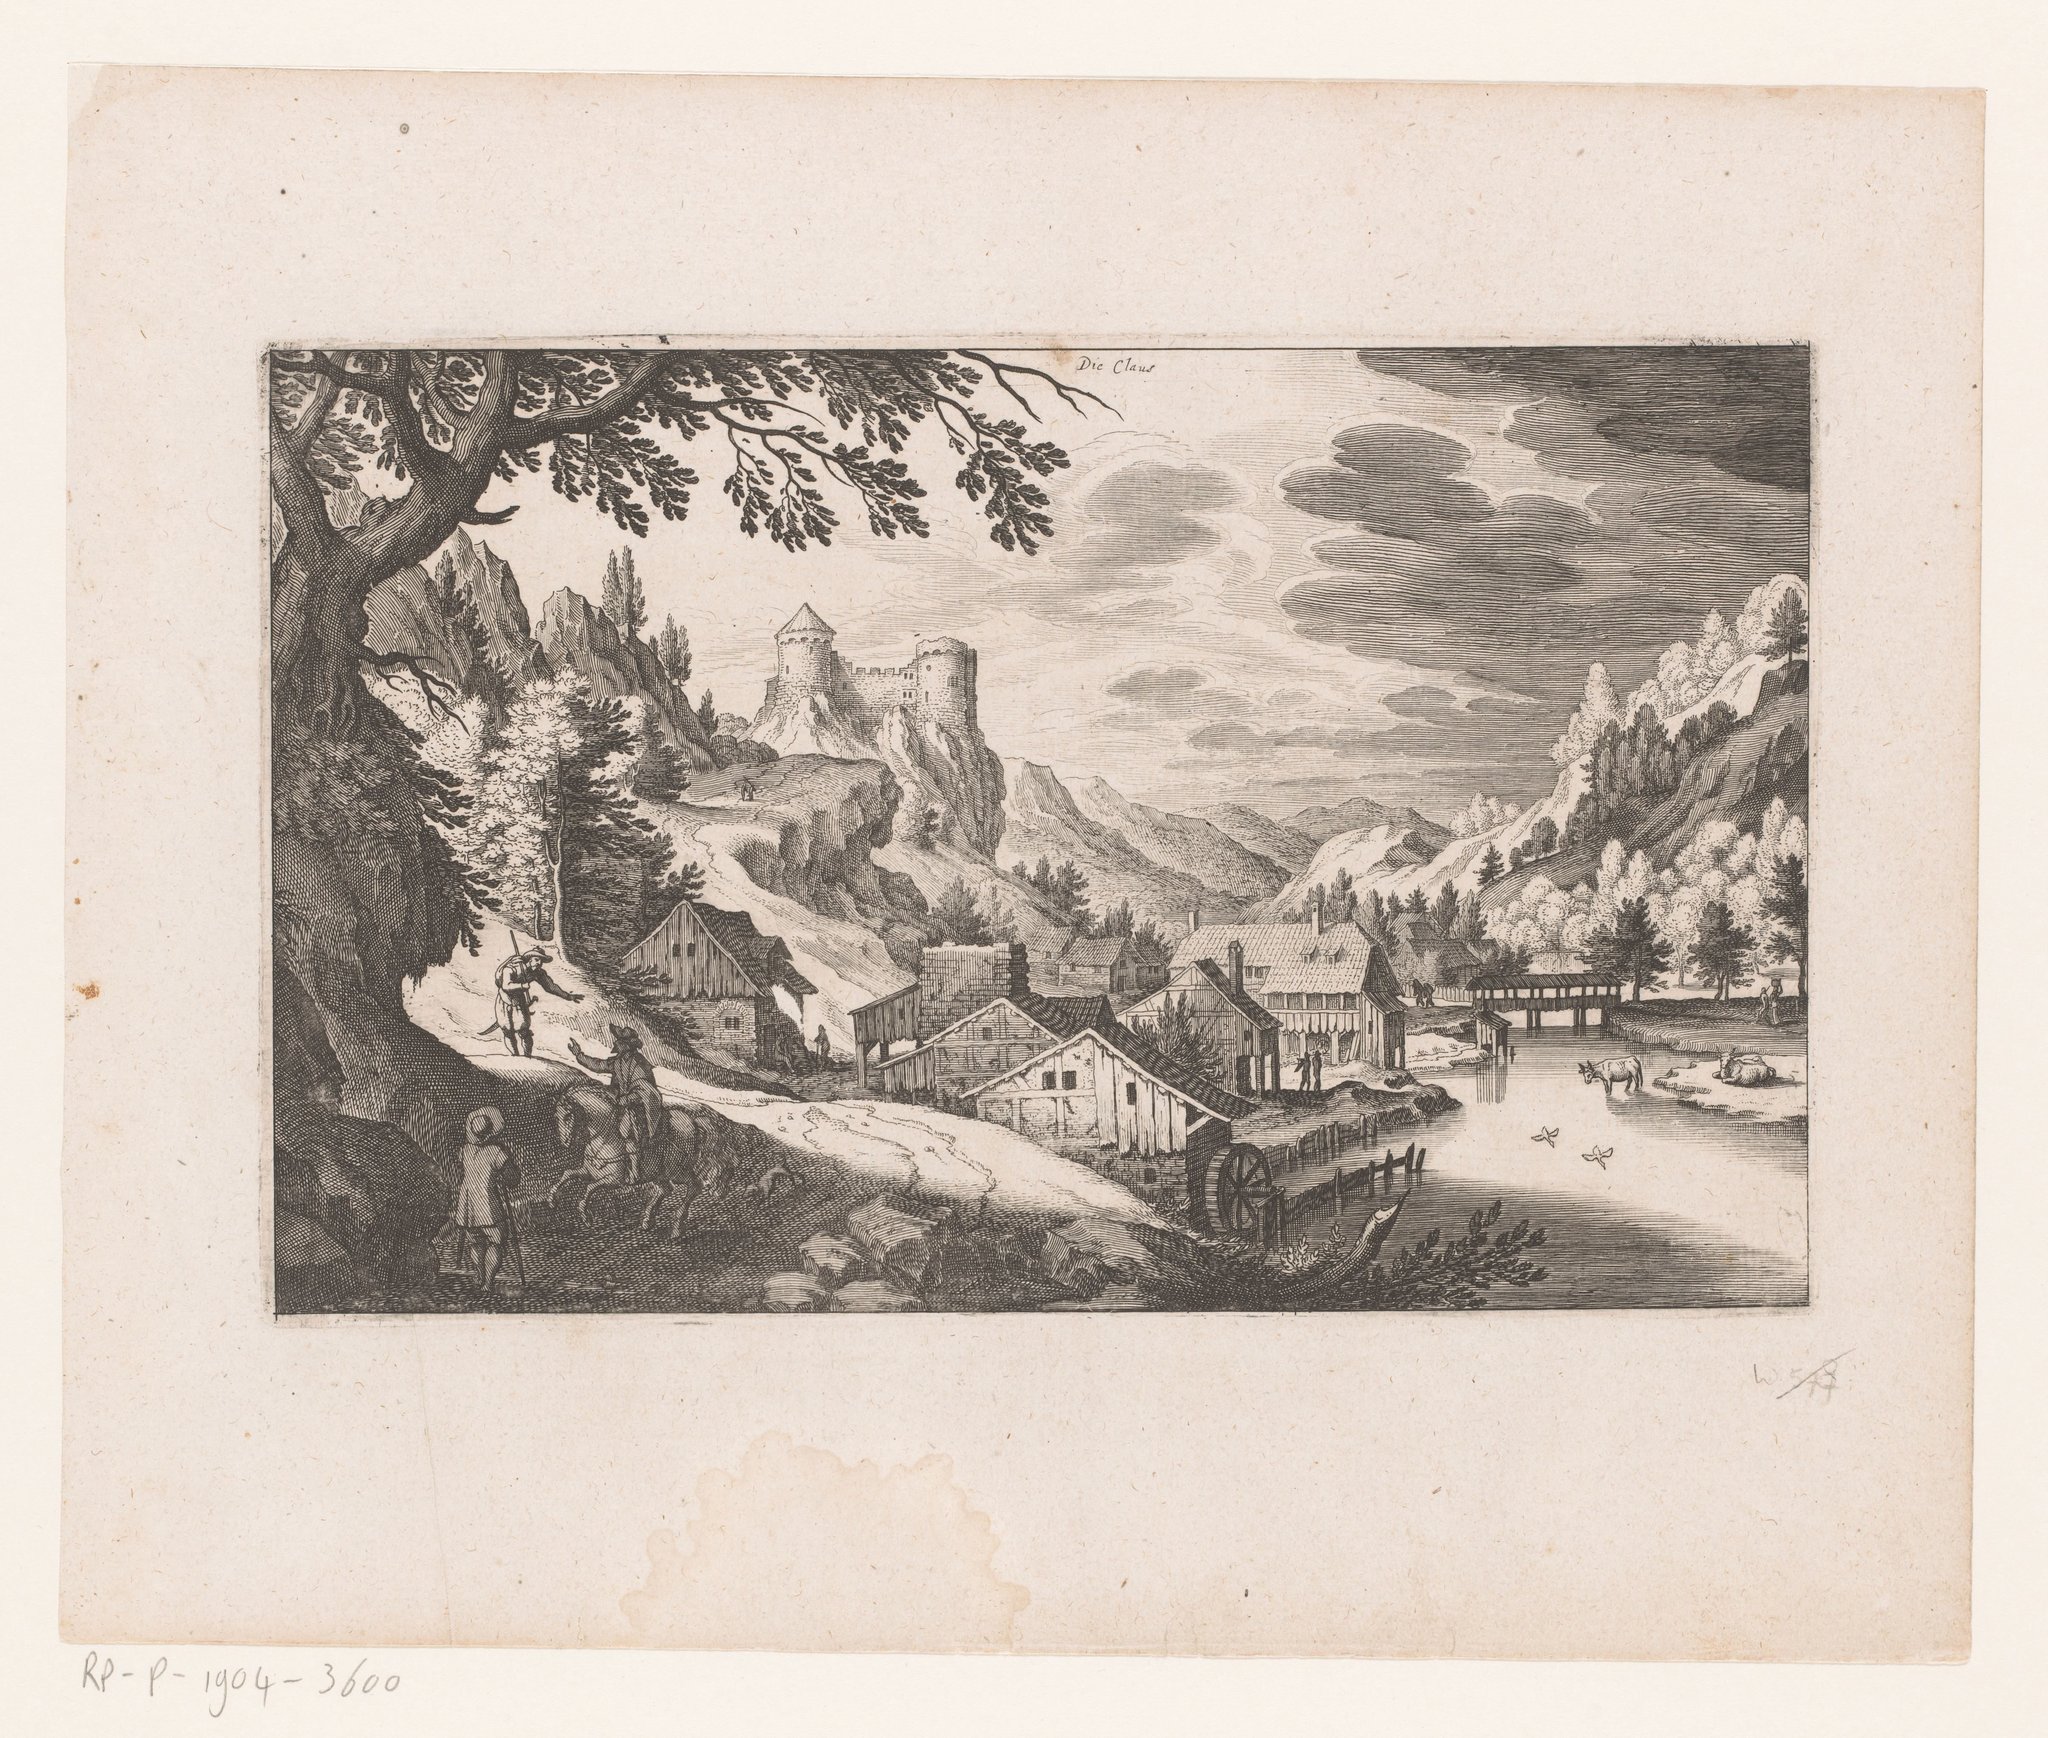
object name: print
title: Berglandschap met rivier, dorp en kasteel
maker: matthäus merian (i)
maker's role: print maker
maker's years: 1593-1650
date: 1624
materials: paper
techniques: etching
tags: castle, landscapes with waters, waterscapes, seascapes (in the temperate zone), village, mountains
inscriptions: collector's mark: Lugt 2228